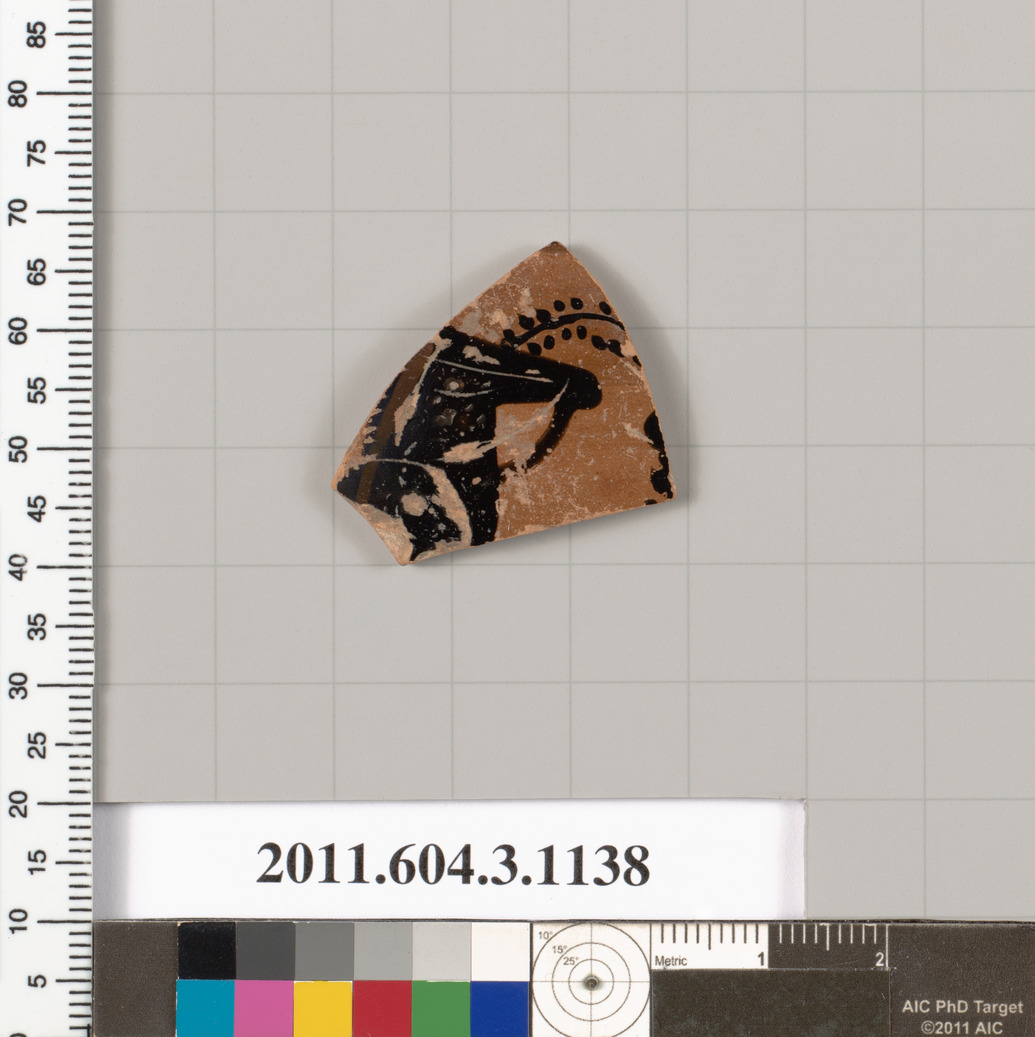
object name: mastoid or kyathos fragment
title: Terracotta fragment of a mastoid (drinking cup with narrow base) or a kyathos (cup-shaped ladle)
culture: greek, attic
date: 534-468 BCE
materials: terracotta